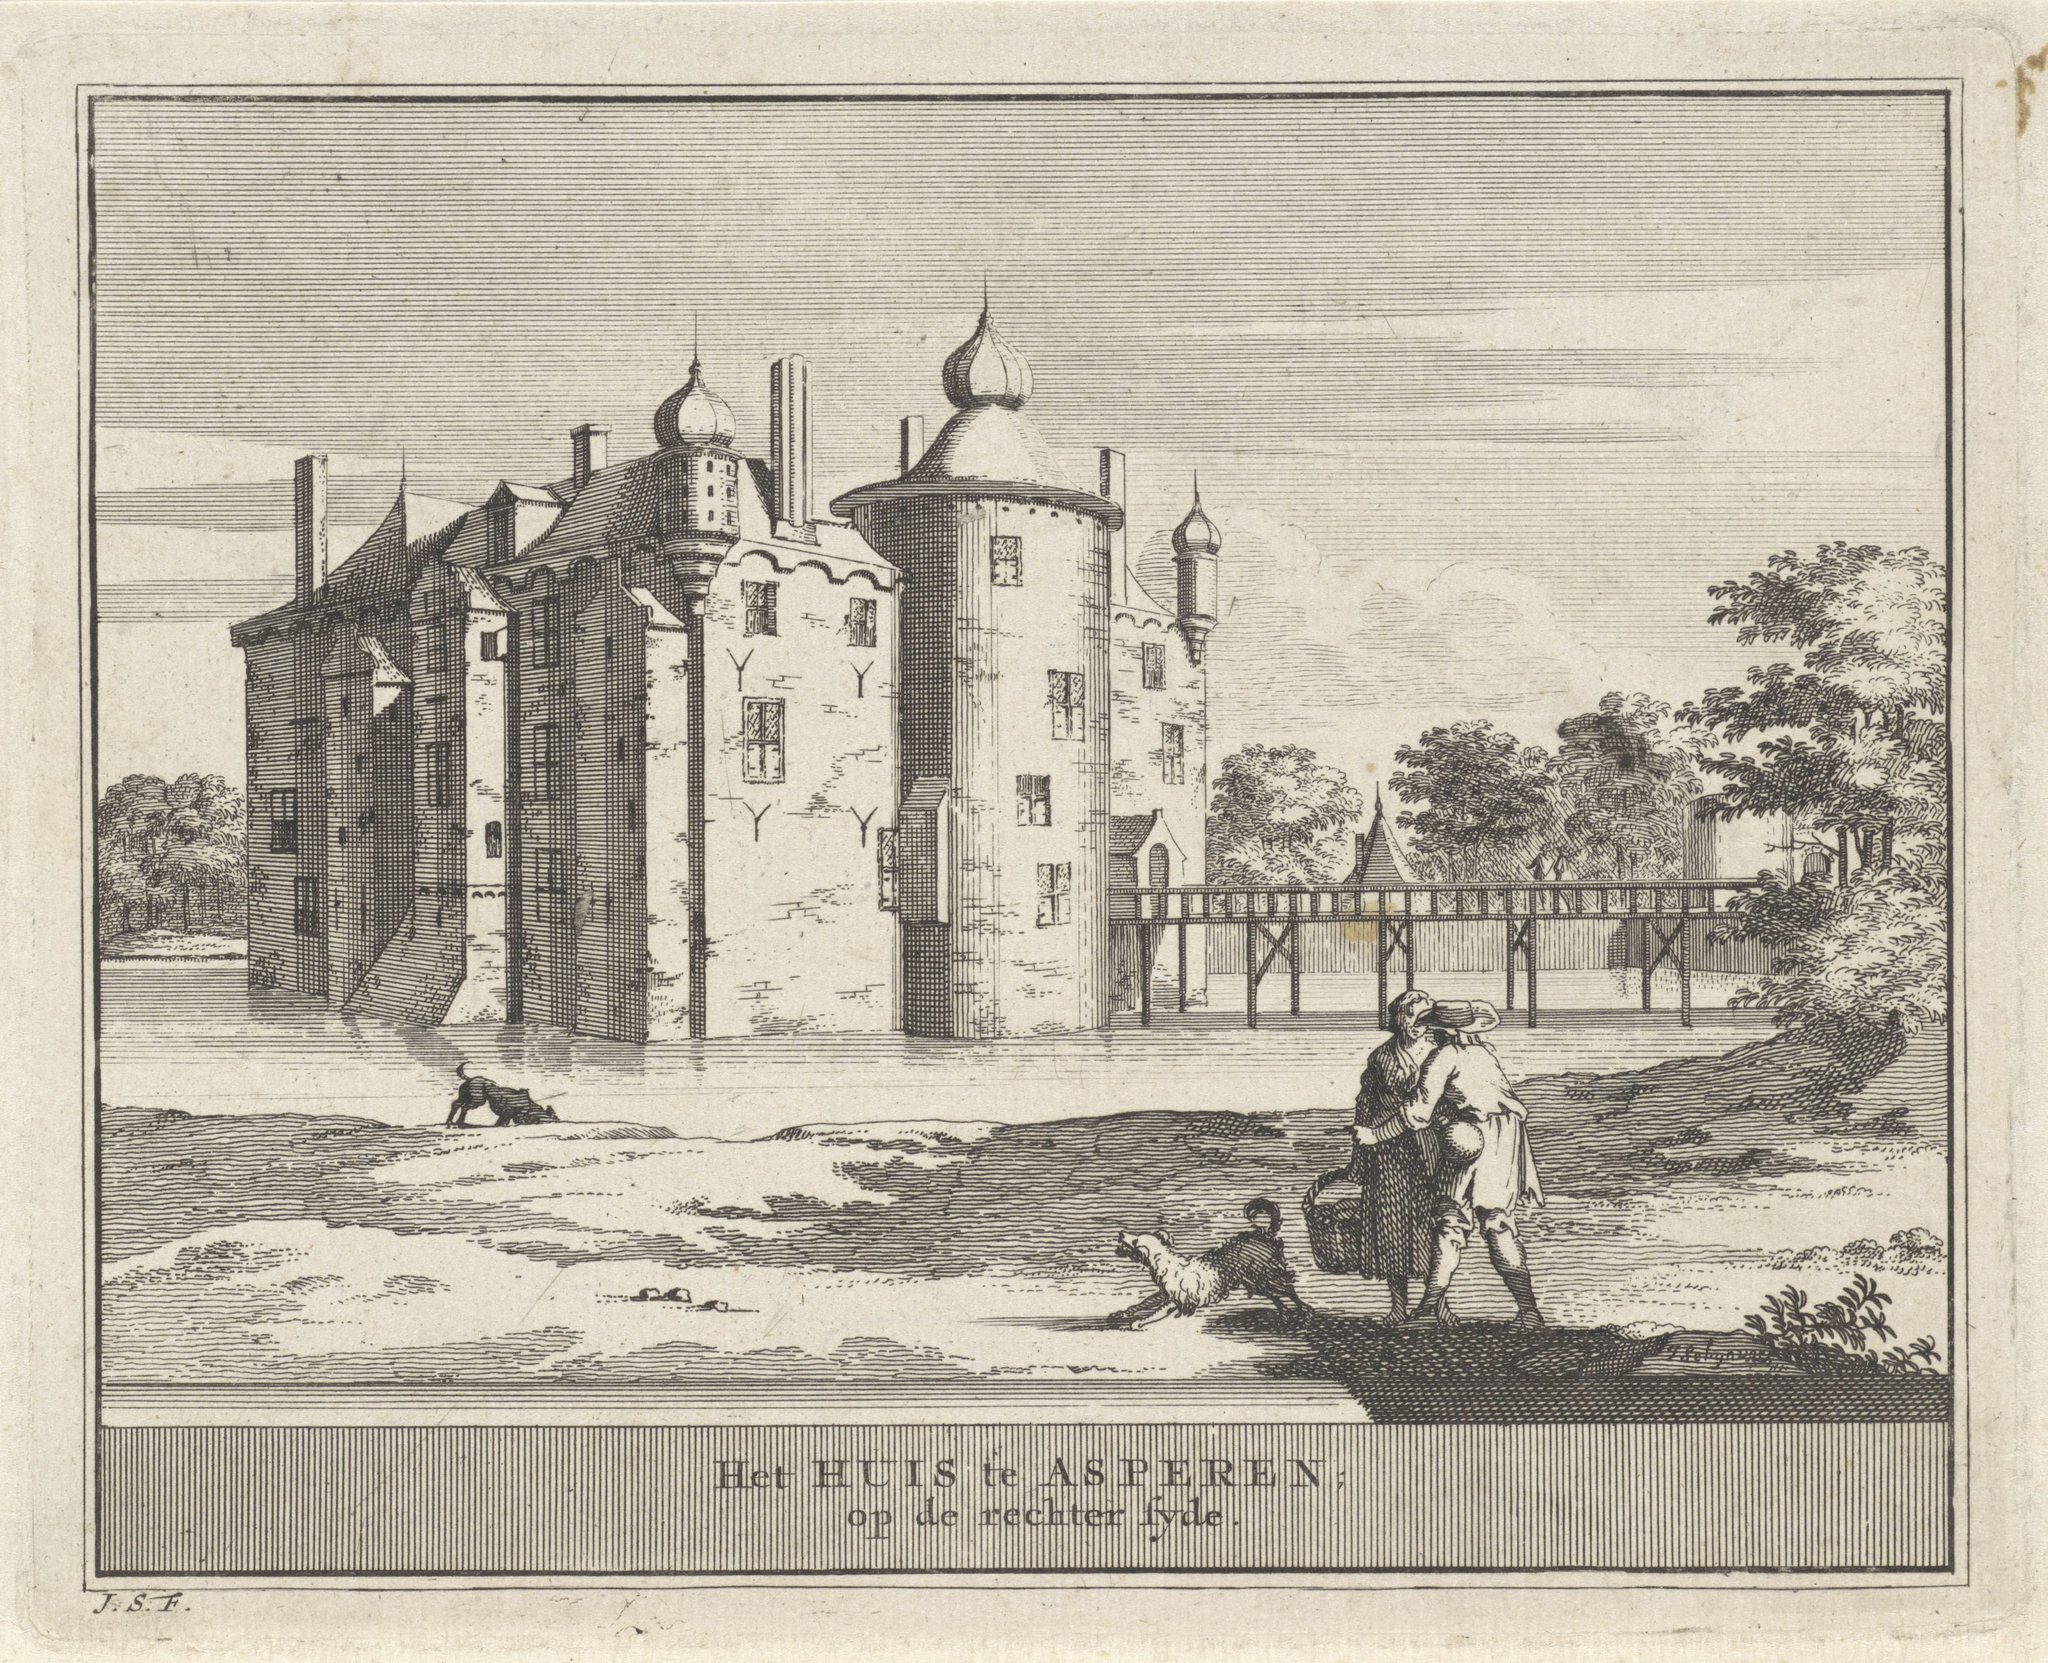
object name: print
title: Gezicht op kasteel Waddestein te Asperen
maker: jacobus schijnvoet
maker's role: draughtsman, print maker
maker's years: 1685-1743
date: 1711-1774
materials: paper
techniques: etching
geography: amsterdam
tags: castle, asperen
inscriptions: collector's mark: Lugt 2228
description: Prent als illustratie opgenomen in: Smids, Ludolph. Schatkamer der Nederlandsse[!] oudheden; of Woordenboek, behelsende Nederlands steden, Amsterdam: Pieter de Coup, 1711. Verscheen tevens in de heruitgave van voorgenoemd werk in 1737 en 1774. In 1721 verscheen er een uitgave met alleen de prenten: Nederlandsche oudheden, bestaande in zestig verbeeldingen (...) gelegen in Holland, 't Sticht van Utrecht en Gelderland enz. Amsterdam: Hendrik Bosch, 1721.